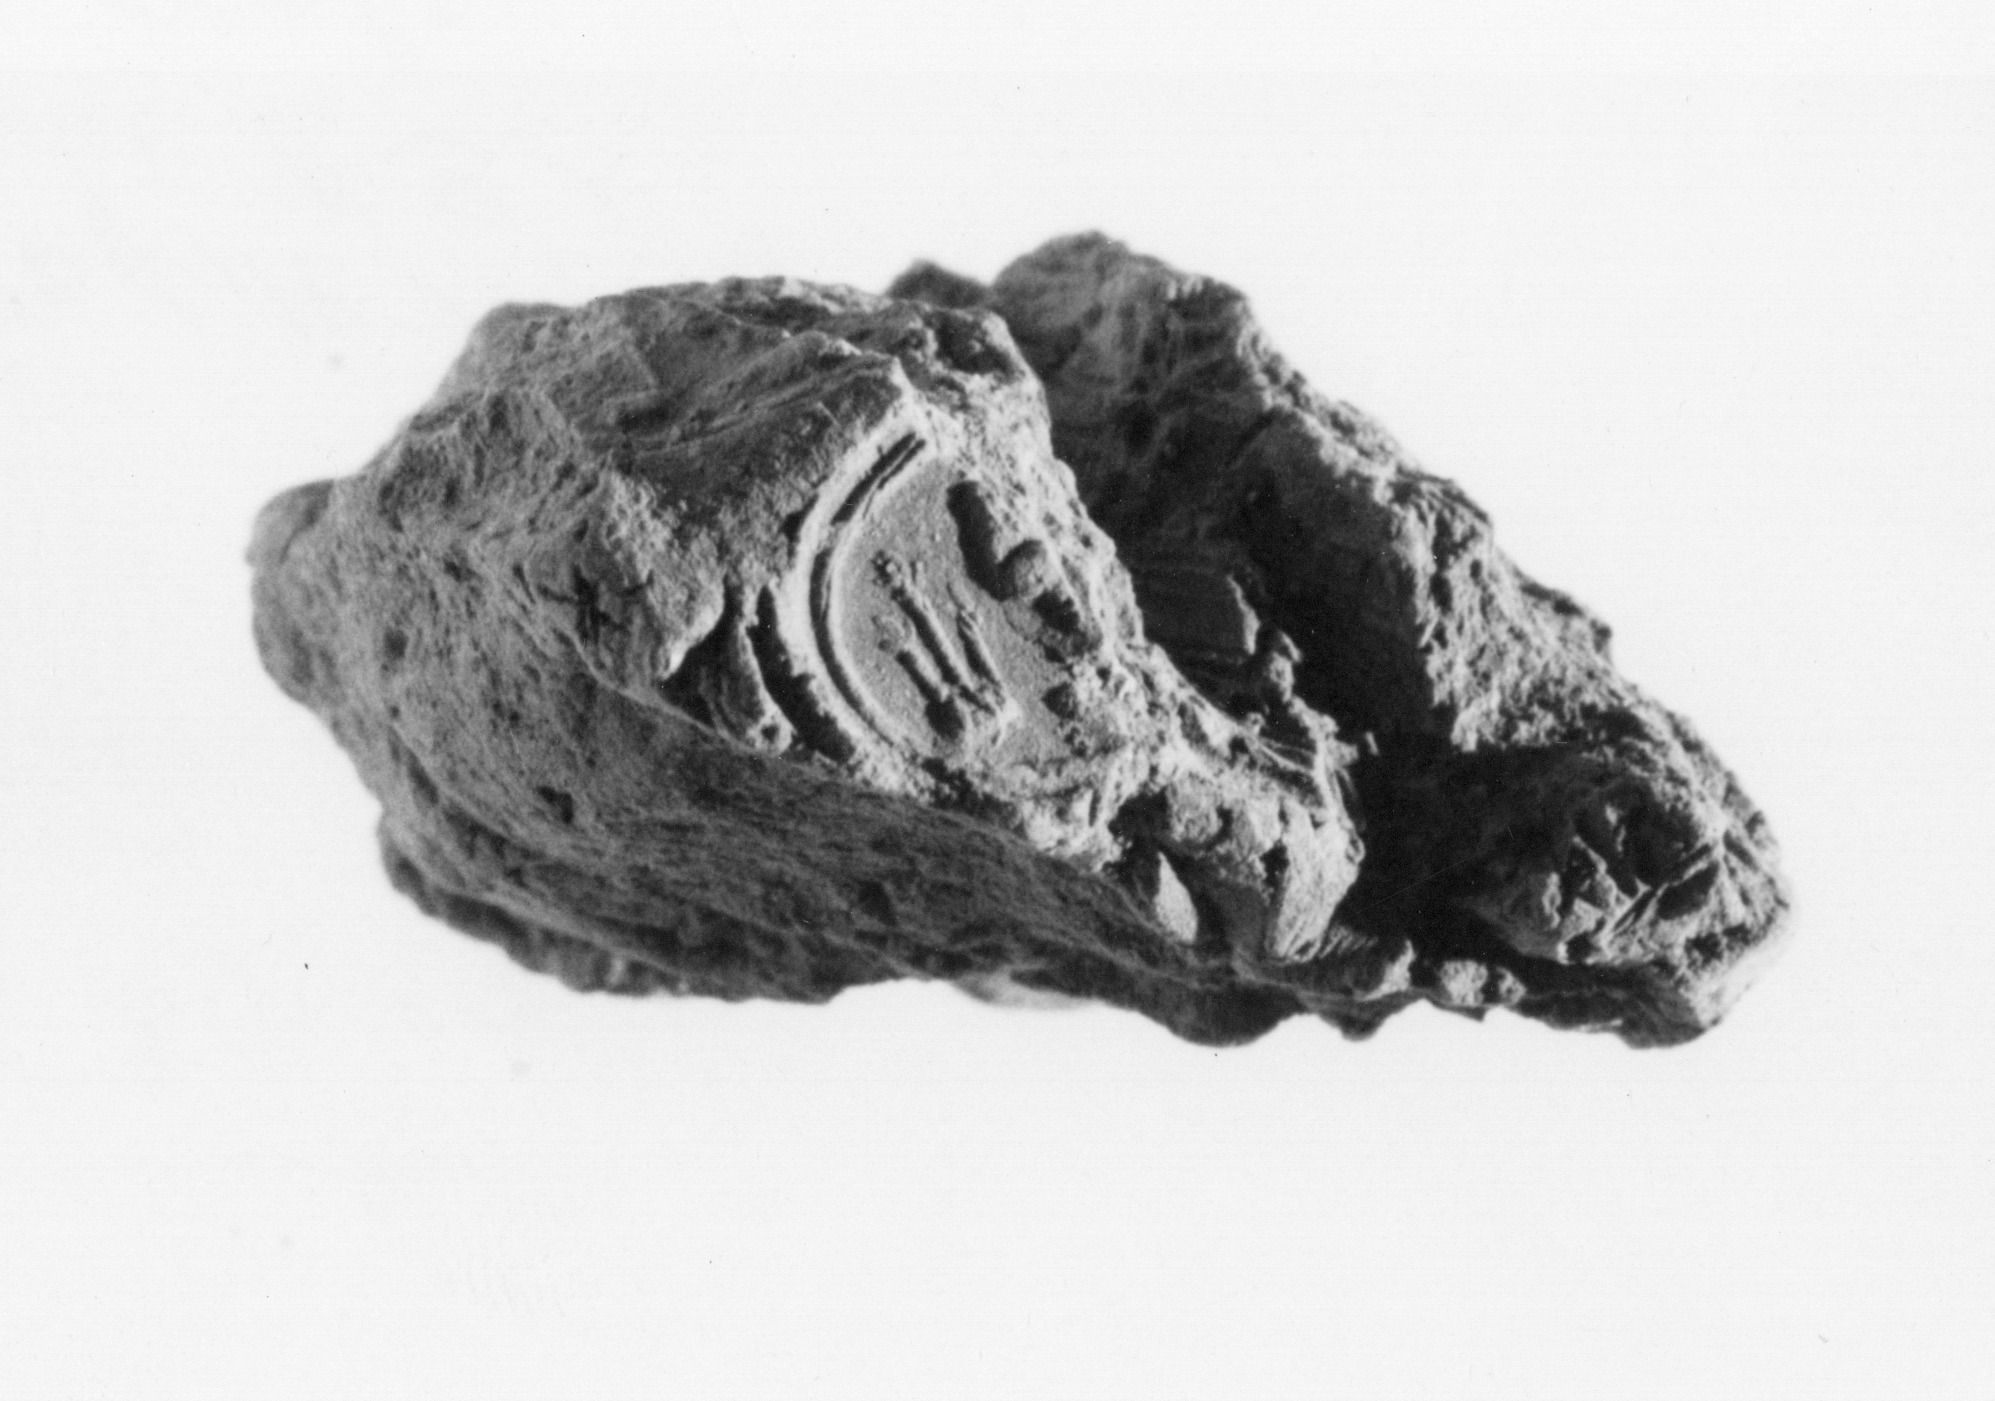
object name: sealing, upper egypt, lower egypt, amun re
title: Document Sealing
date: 1390-1352 BCE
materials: mud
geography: egypt